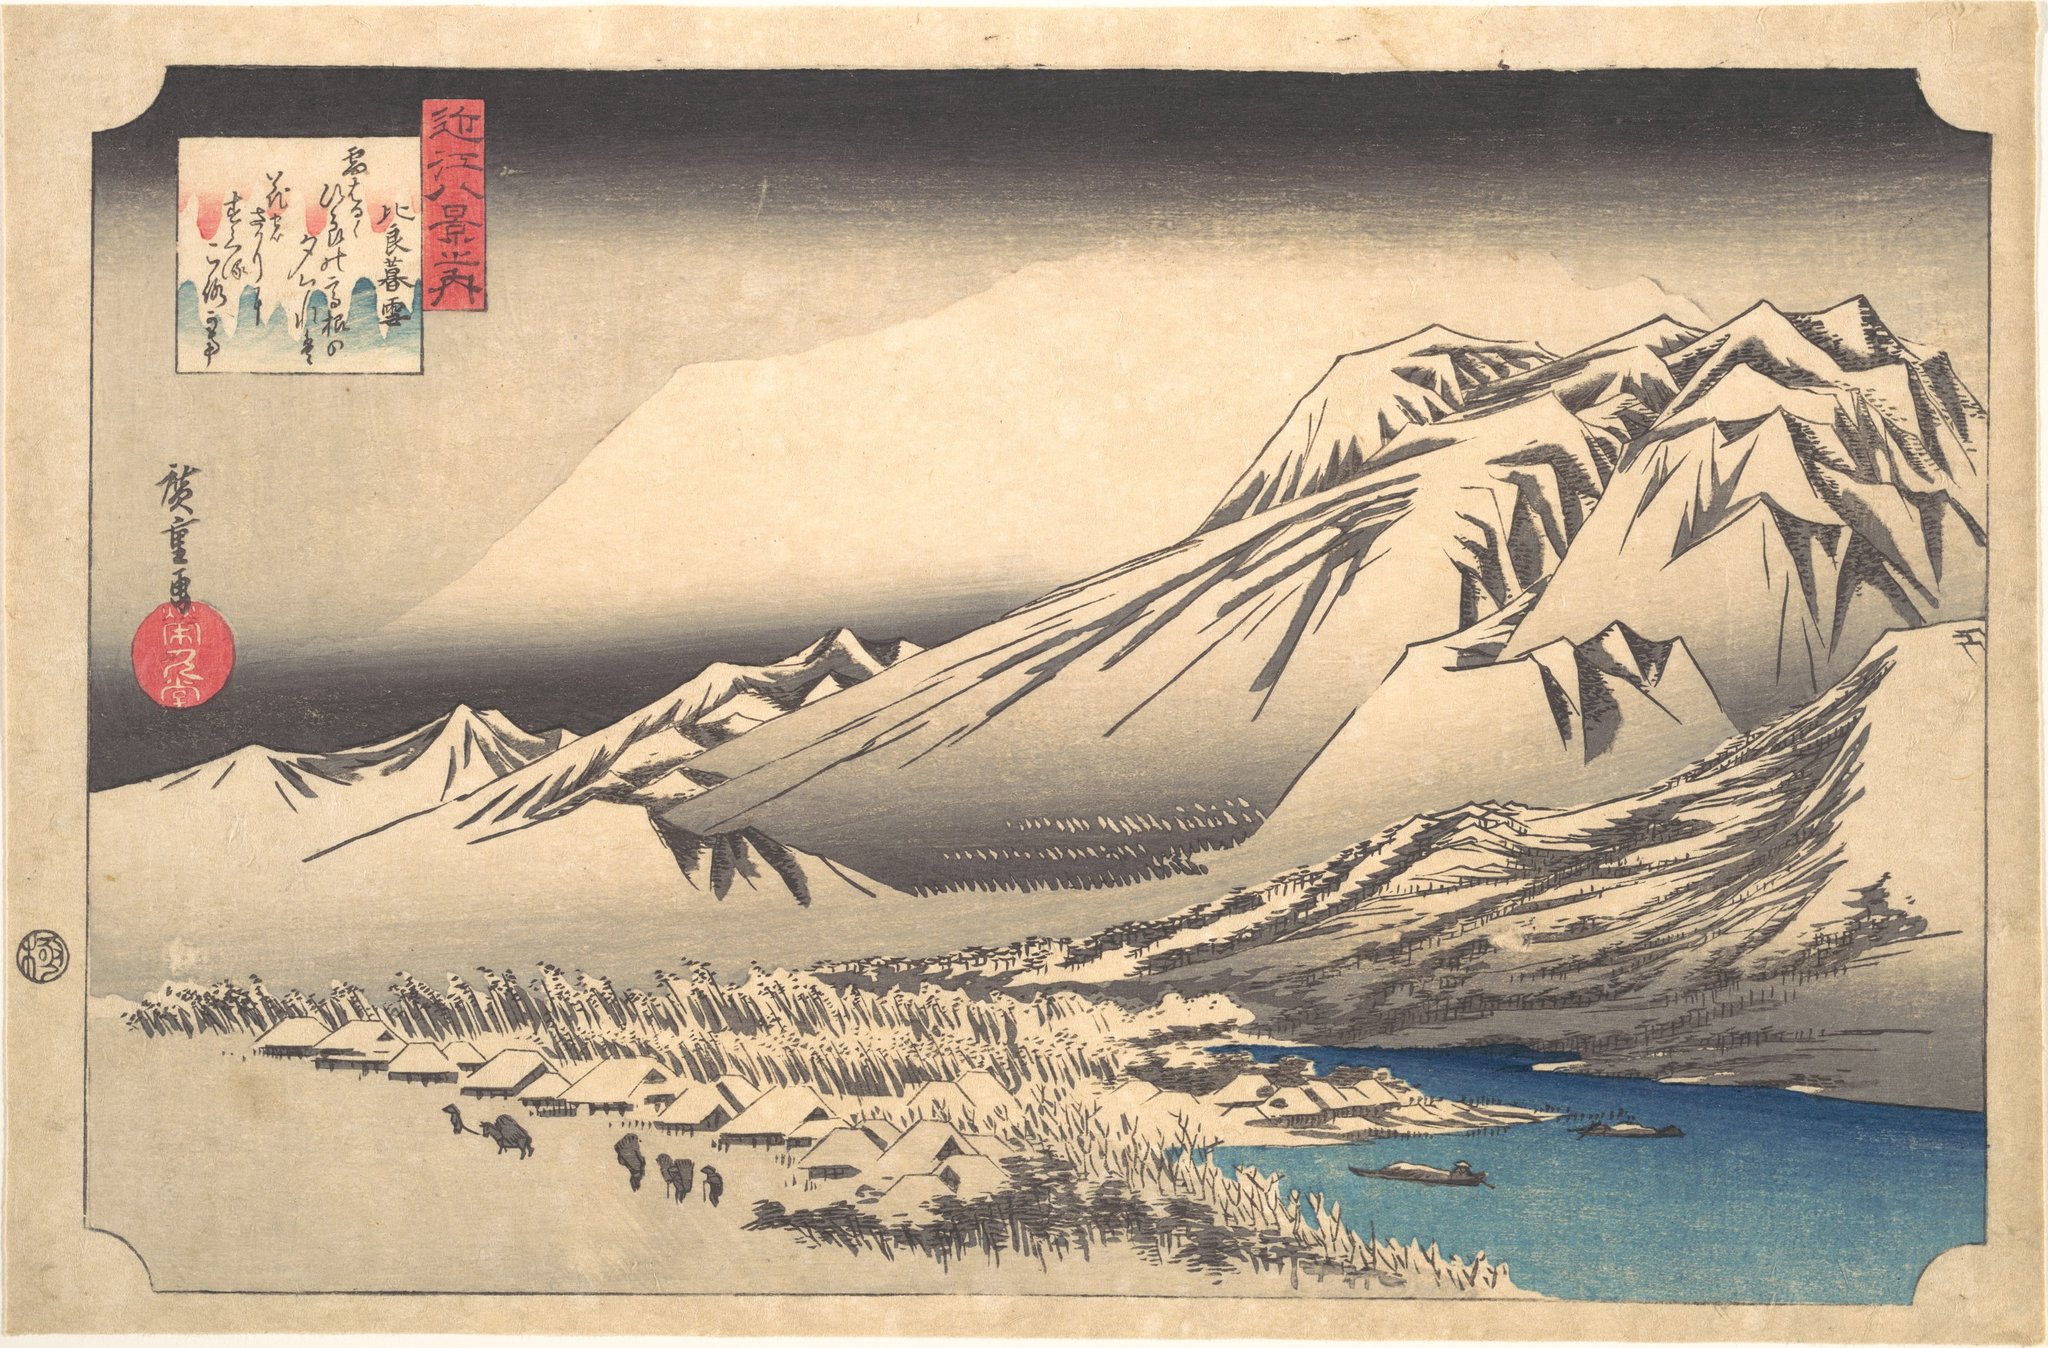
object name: print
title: Evening Snow on Mount Hira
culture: japanese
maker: utagawa hiroshige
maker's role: artist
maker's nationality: japanese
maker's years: 1797-1858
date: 1797-1858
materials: ink, paper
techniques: woodblock print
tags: mountains,landscapes,snow